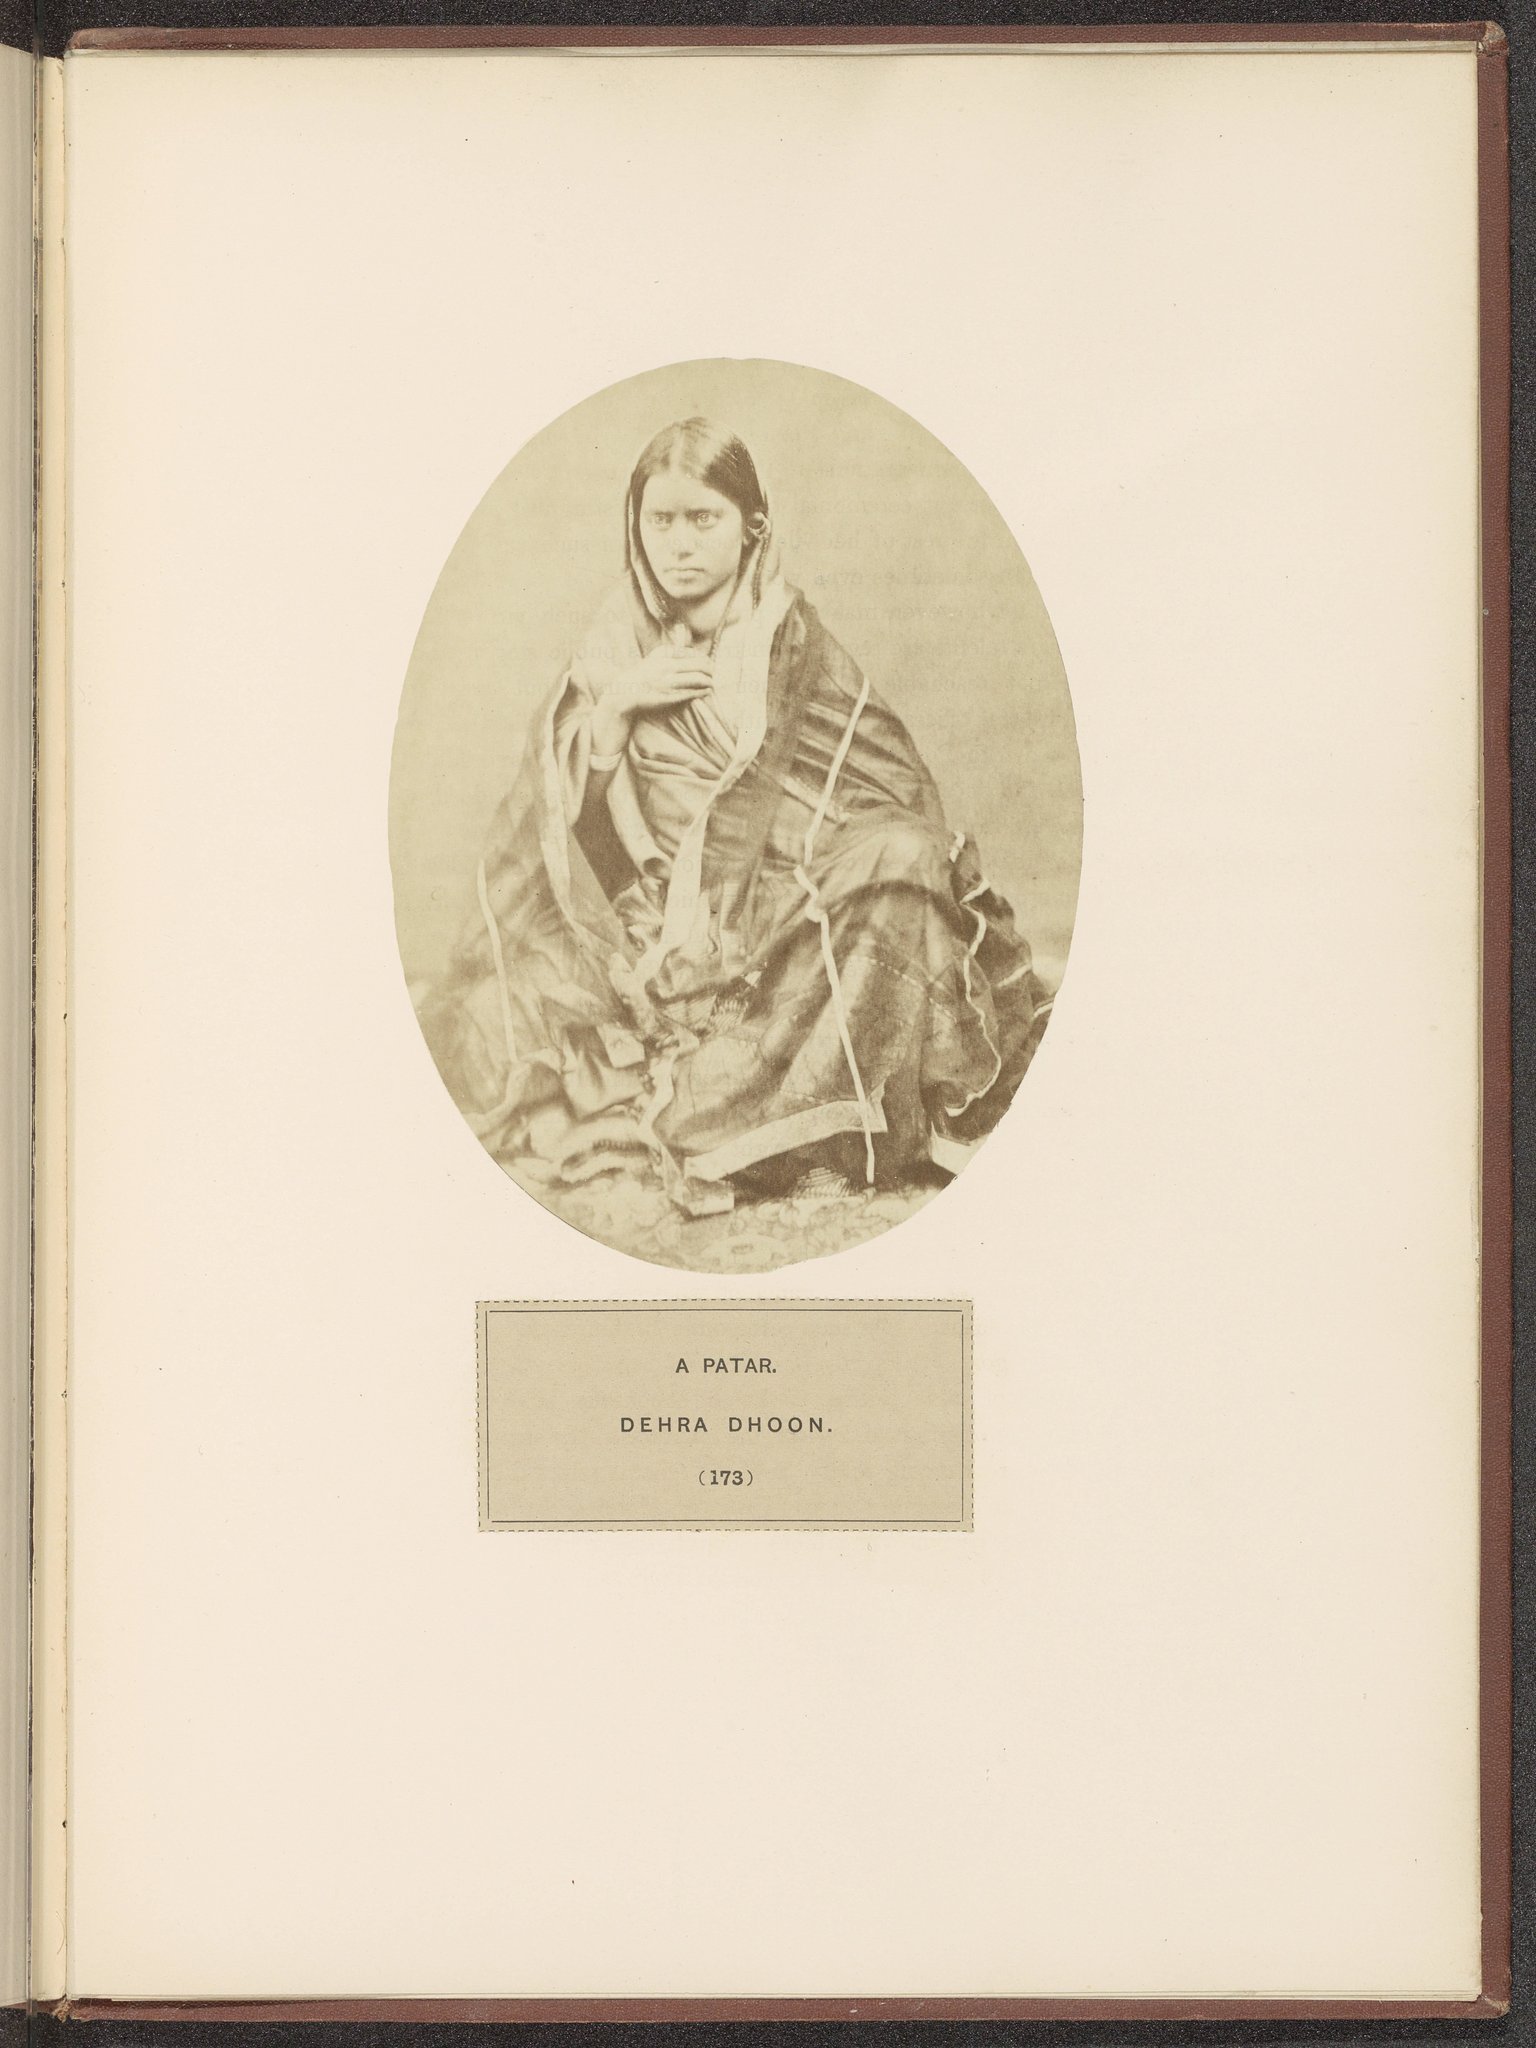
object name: photograph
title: Portrait of a patar (courtesan) from Dehradun, Uttarakhand, India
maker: Anonymous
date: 1858-1868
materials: photographic support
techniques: albumen print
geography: dehradun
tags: courtesan, hetaera, human races; peoples; nationalities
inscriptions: inscription: ‘A PATAR./ DEHRA DHOON.’, number: ‘(173)’